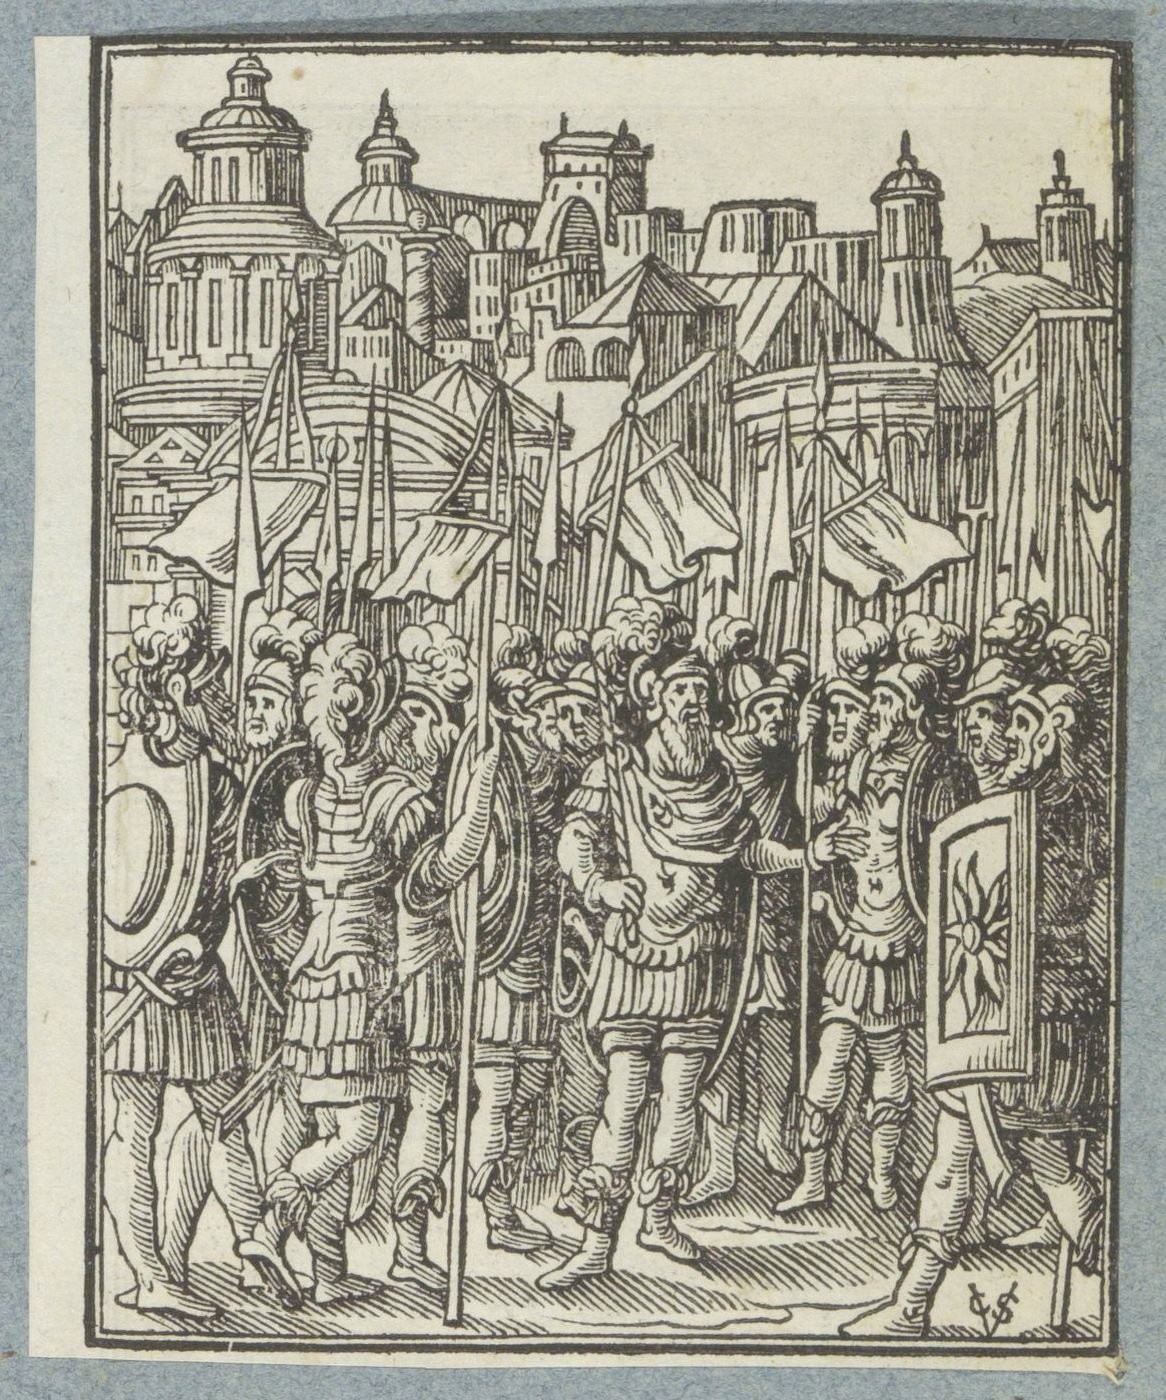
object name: print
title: Krijgslieden voor een stad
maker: pieter jacobsz. paets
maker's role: publisher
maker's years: 1587-1667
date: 1645-1646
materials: paper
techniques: woodcut, pasting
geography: amsterdam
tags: the israelites prepare for battle ~ the siege of bethuliah, the soldier; the soldier's life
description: De prent werd gemaakt voor de uitgaven van P.J. Paets uit Amsterdam. Ze komt in ieder geval voor in: Bibels Tresoor ofte der zielen lusthof. Amsterdam, P.J. Paets, 1646. Mogelijk ook in: Historien ende Prophetien. [Amsterdam], P.J. Paets, 1645.